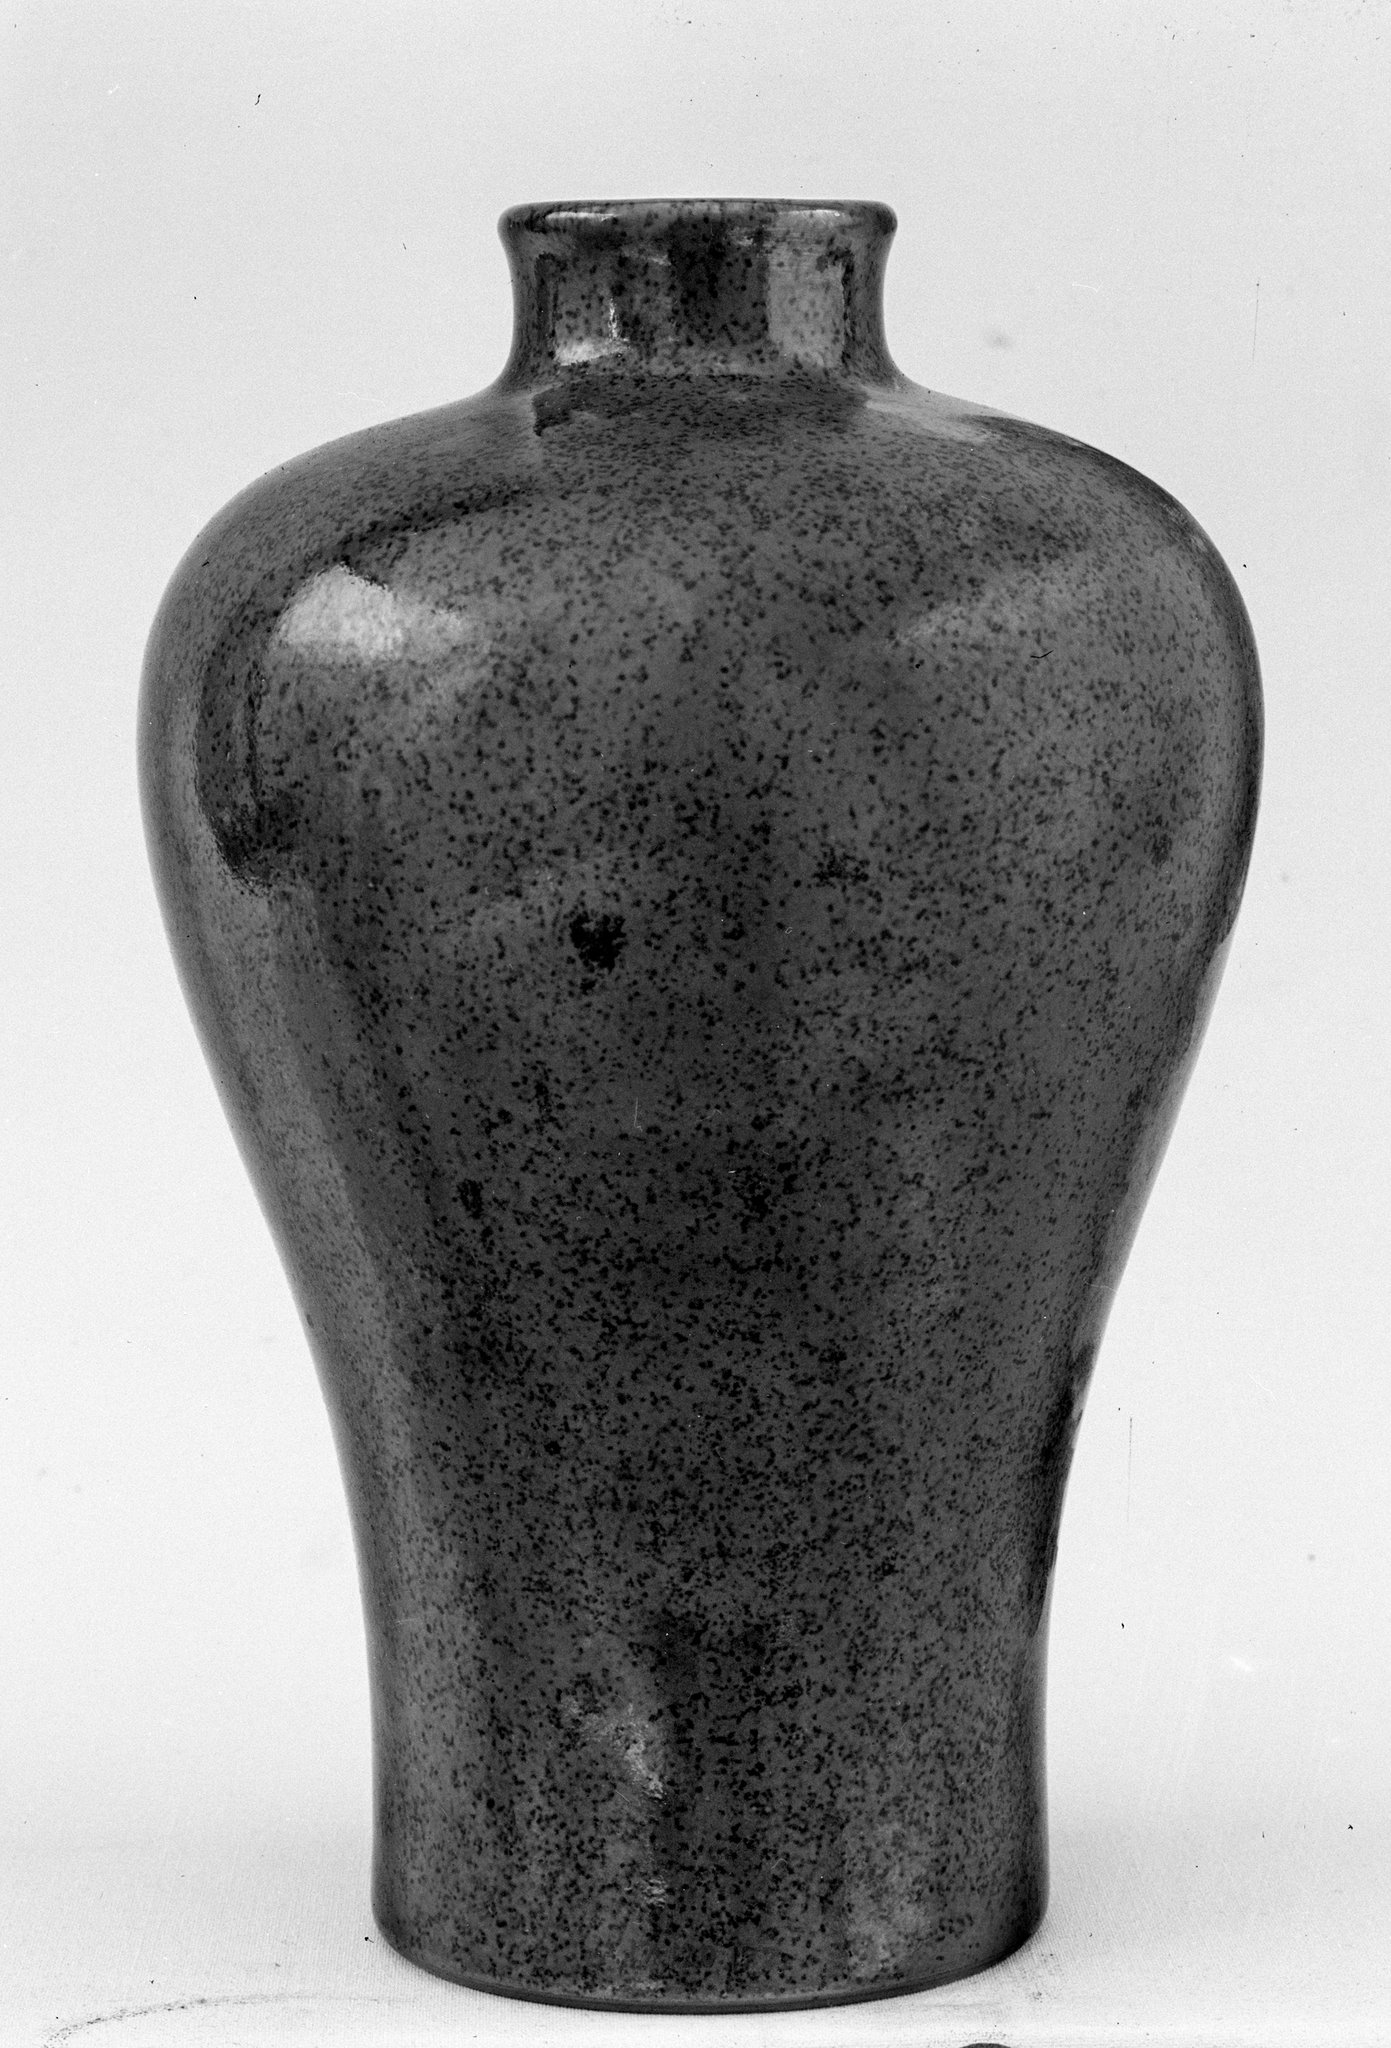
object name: vase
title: Meiping vase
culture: chinese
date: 1701-1733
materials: glaze, porcelain